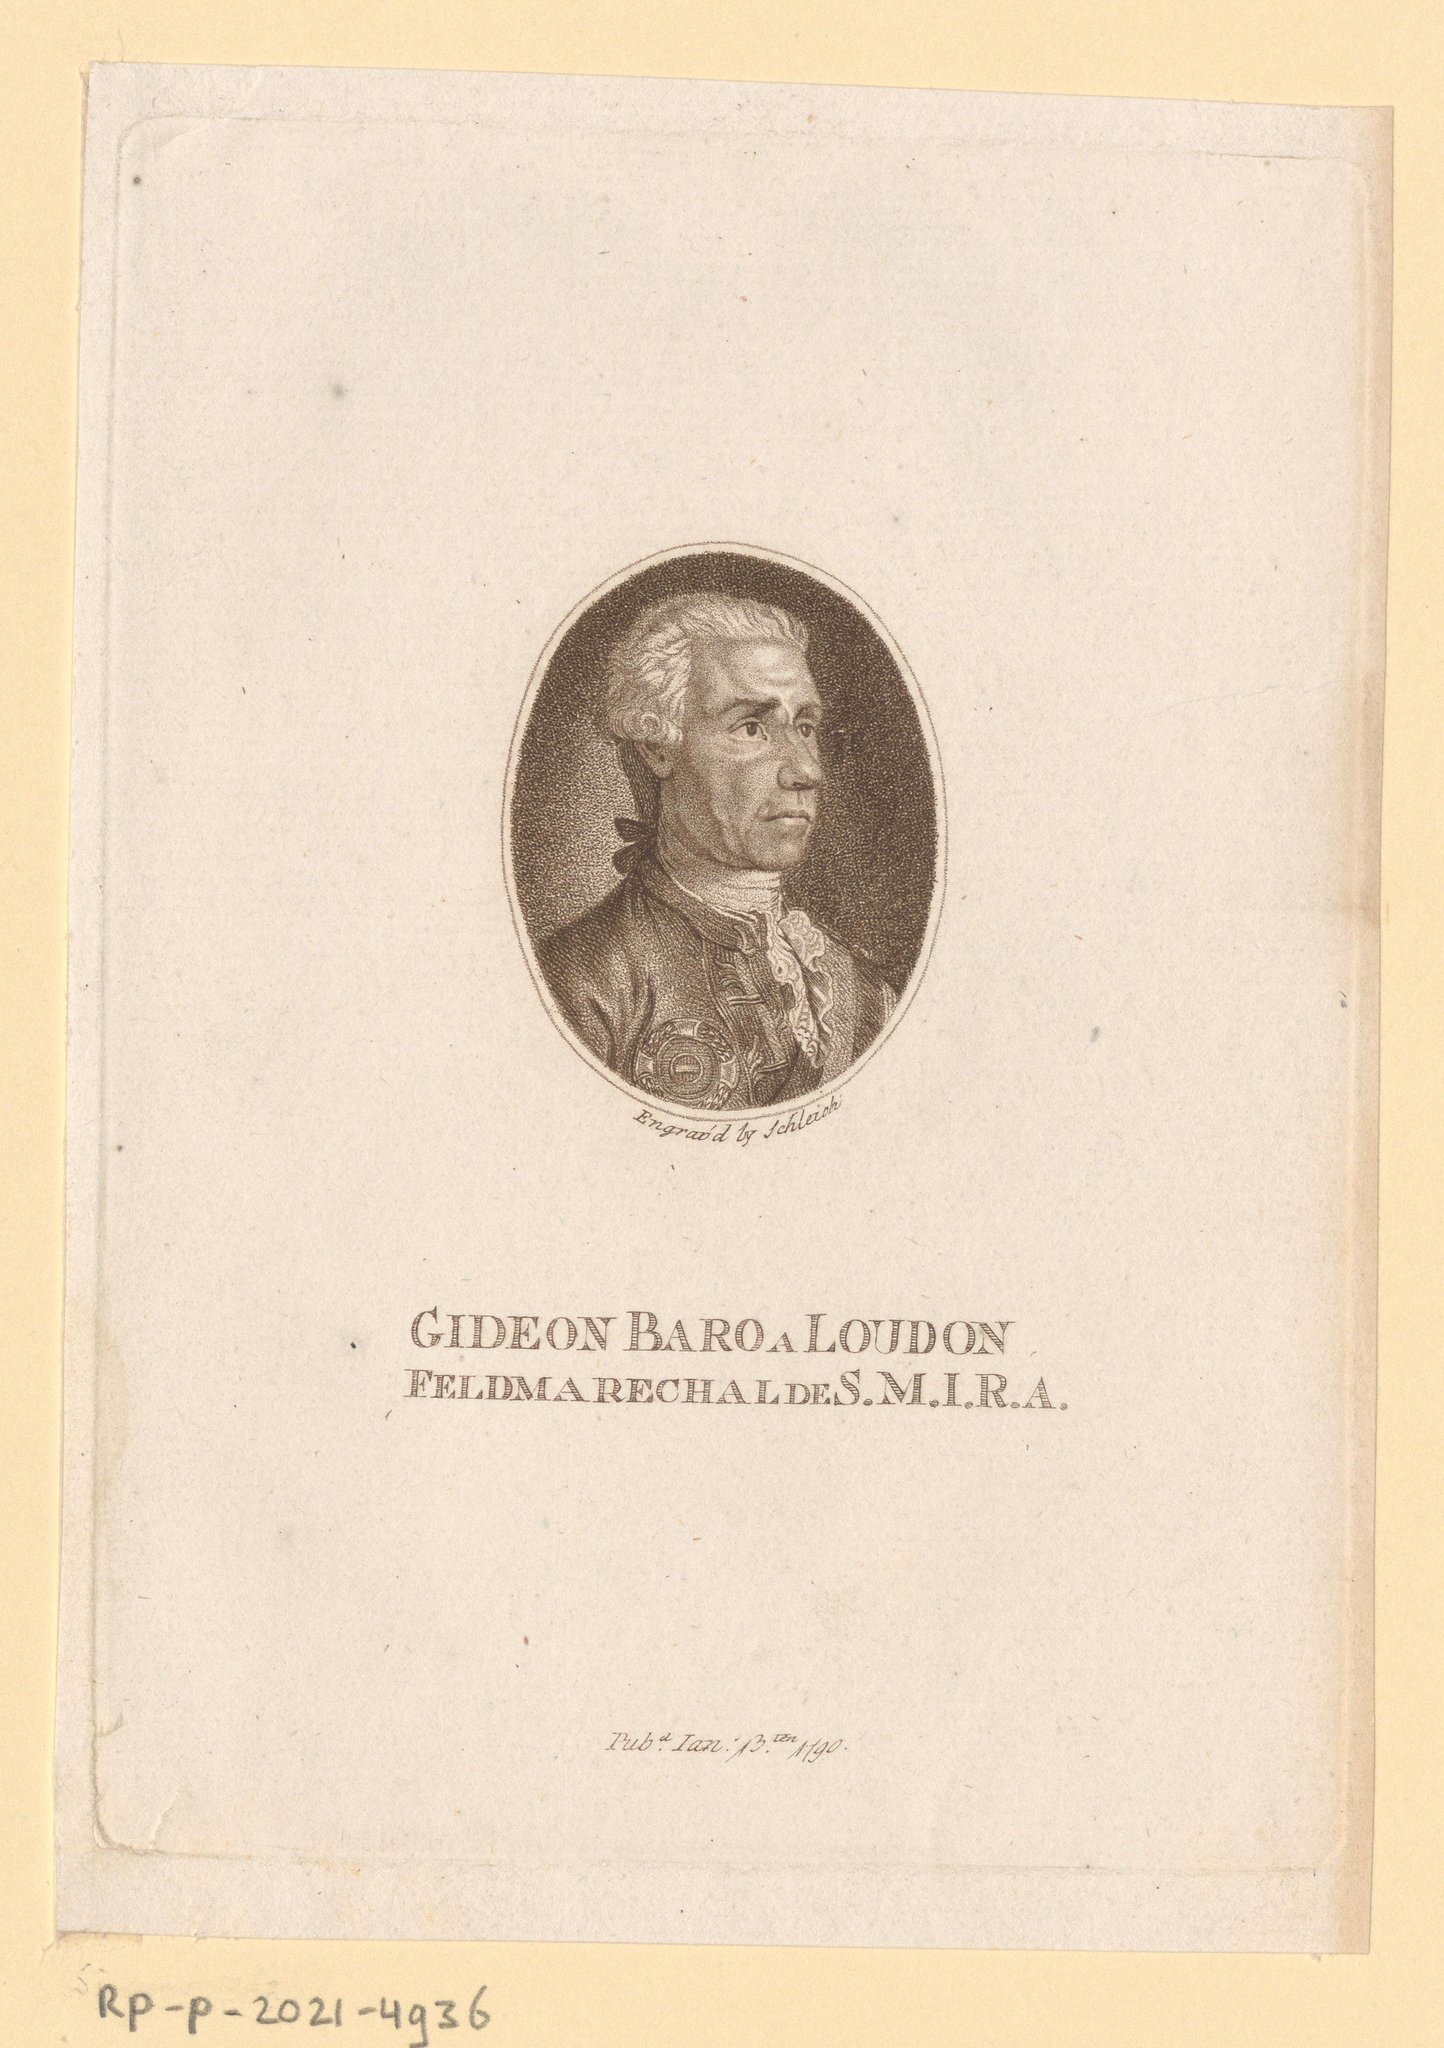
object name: print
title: Portret van Gideon Ernst von Laudon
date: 1790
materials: paper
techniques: stippling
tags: historical persons, wig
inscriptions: date